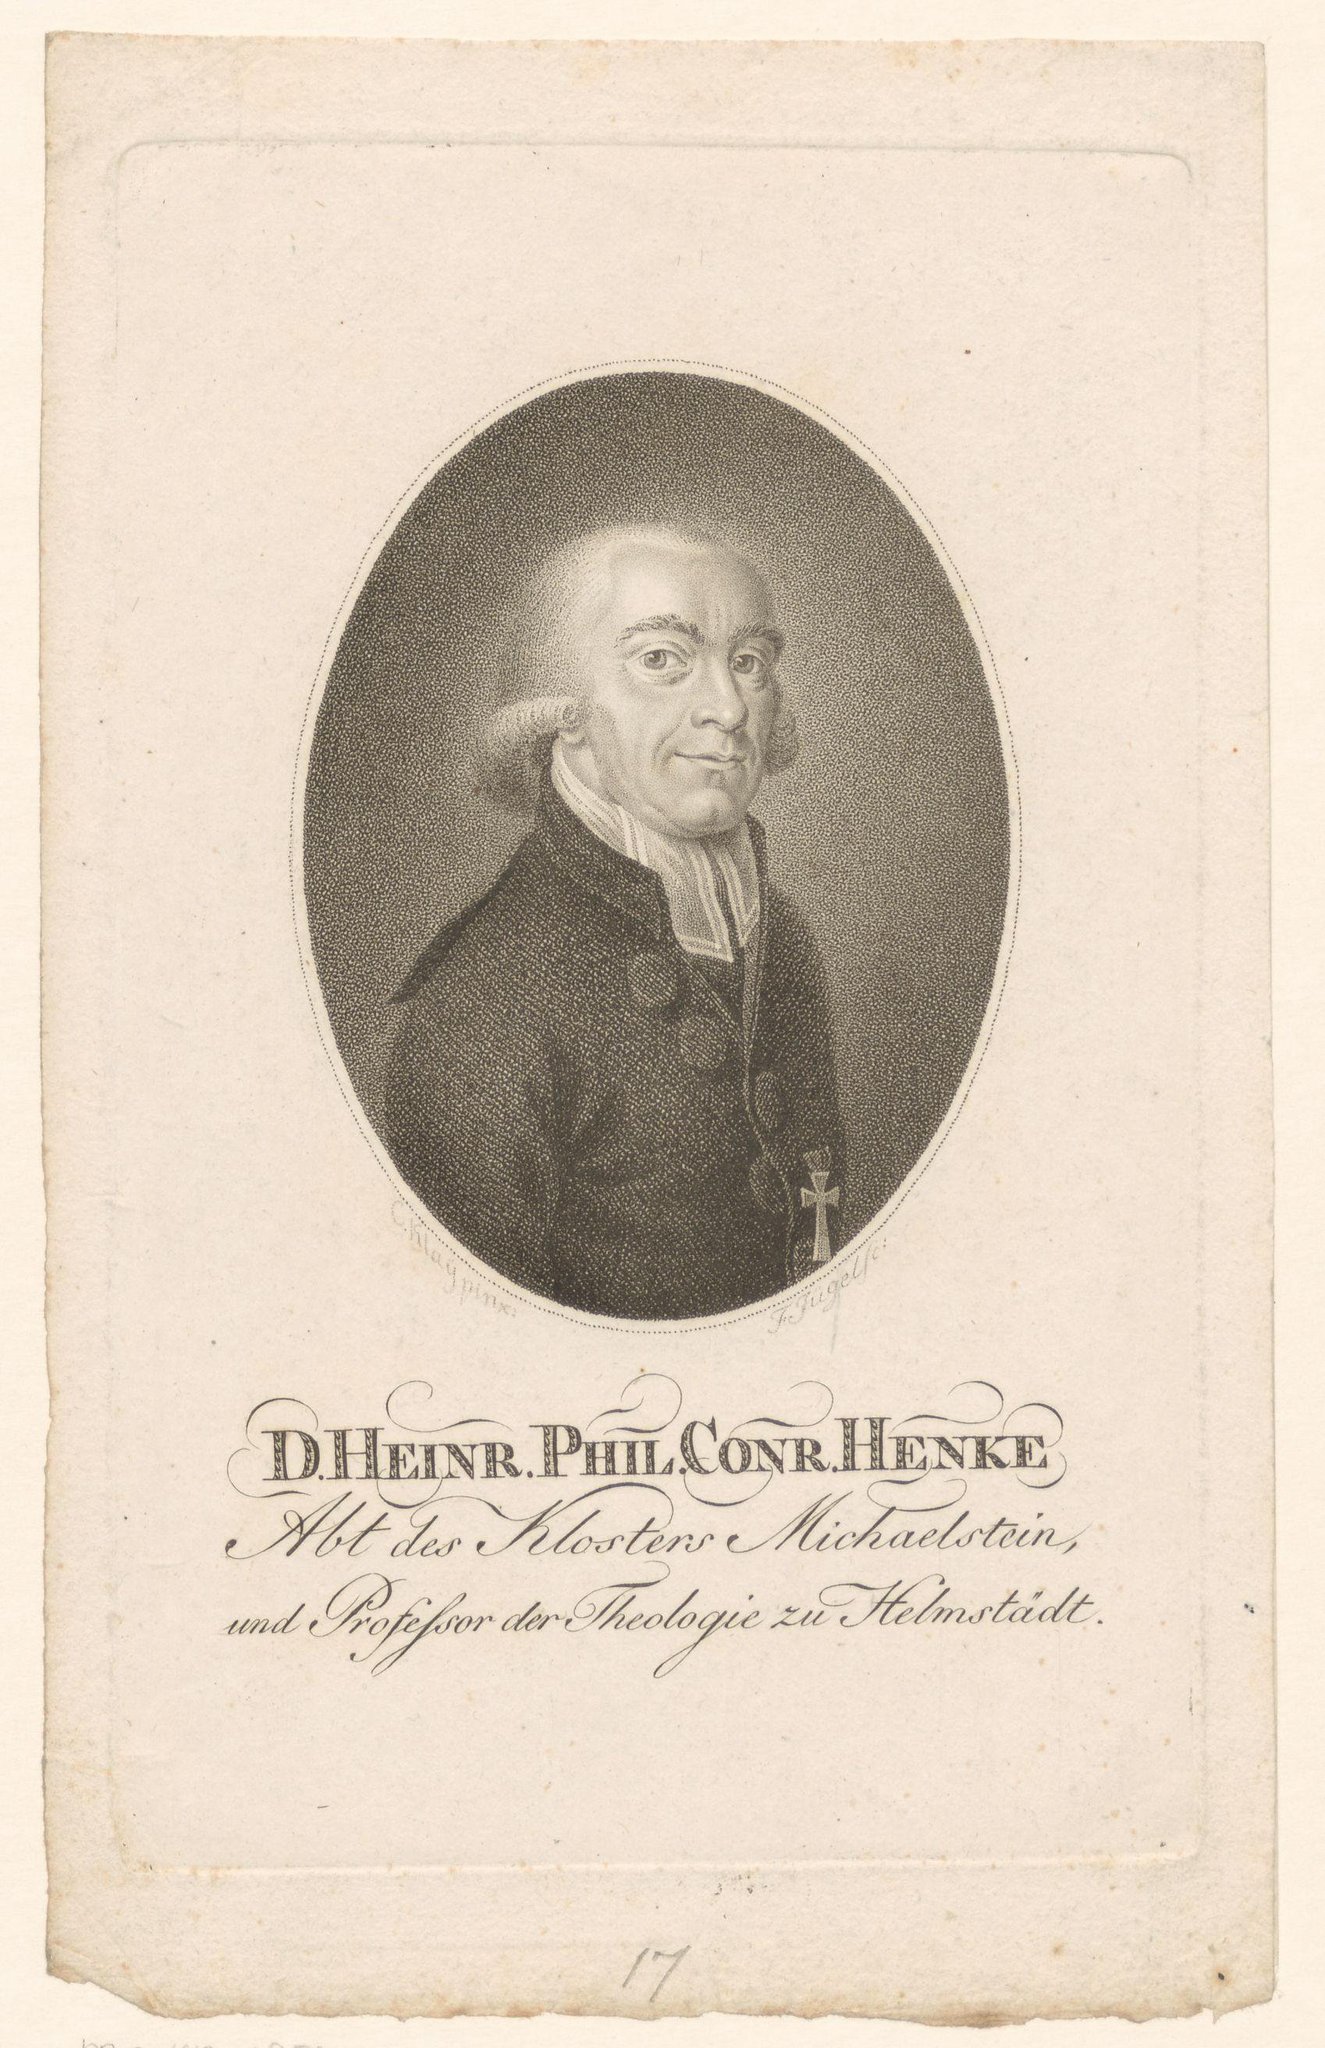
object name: print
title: Portret van Heinrich Philipp Conrad Henke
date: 1782-1833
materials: paper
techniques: stippling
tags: theologian, historical persons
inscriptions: collector's mark: Lugt 2228